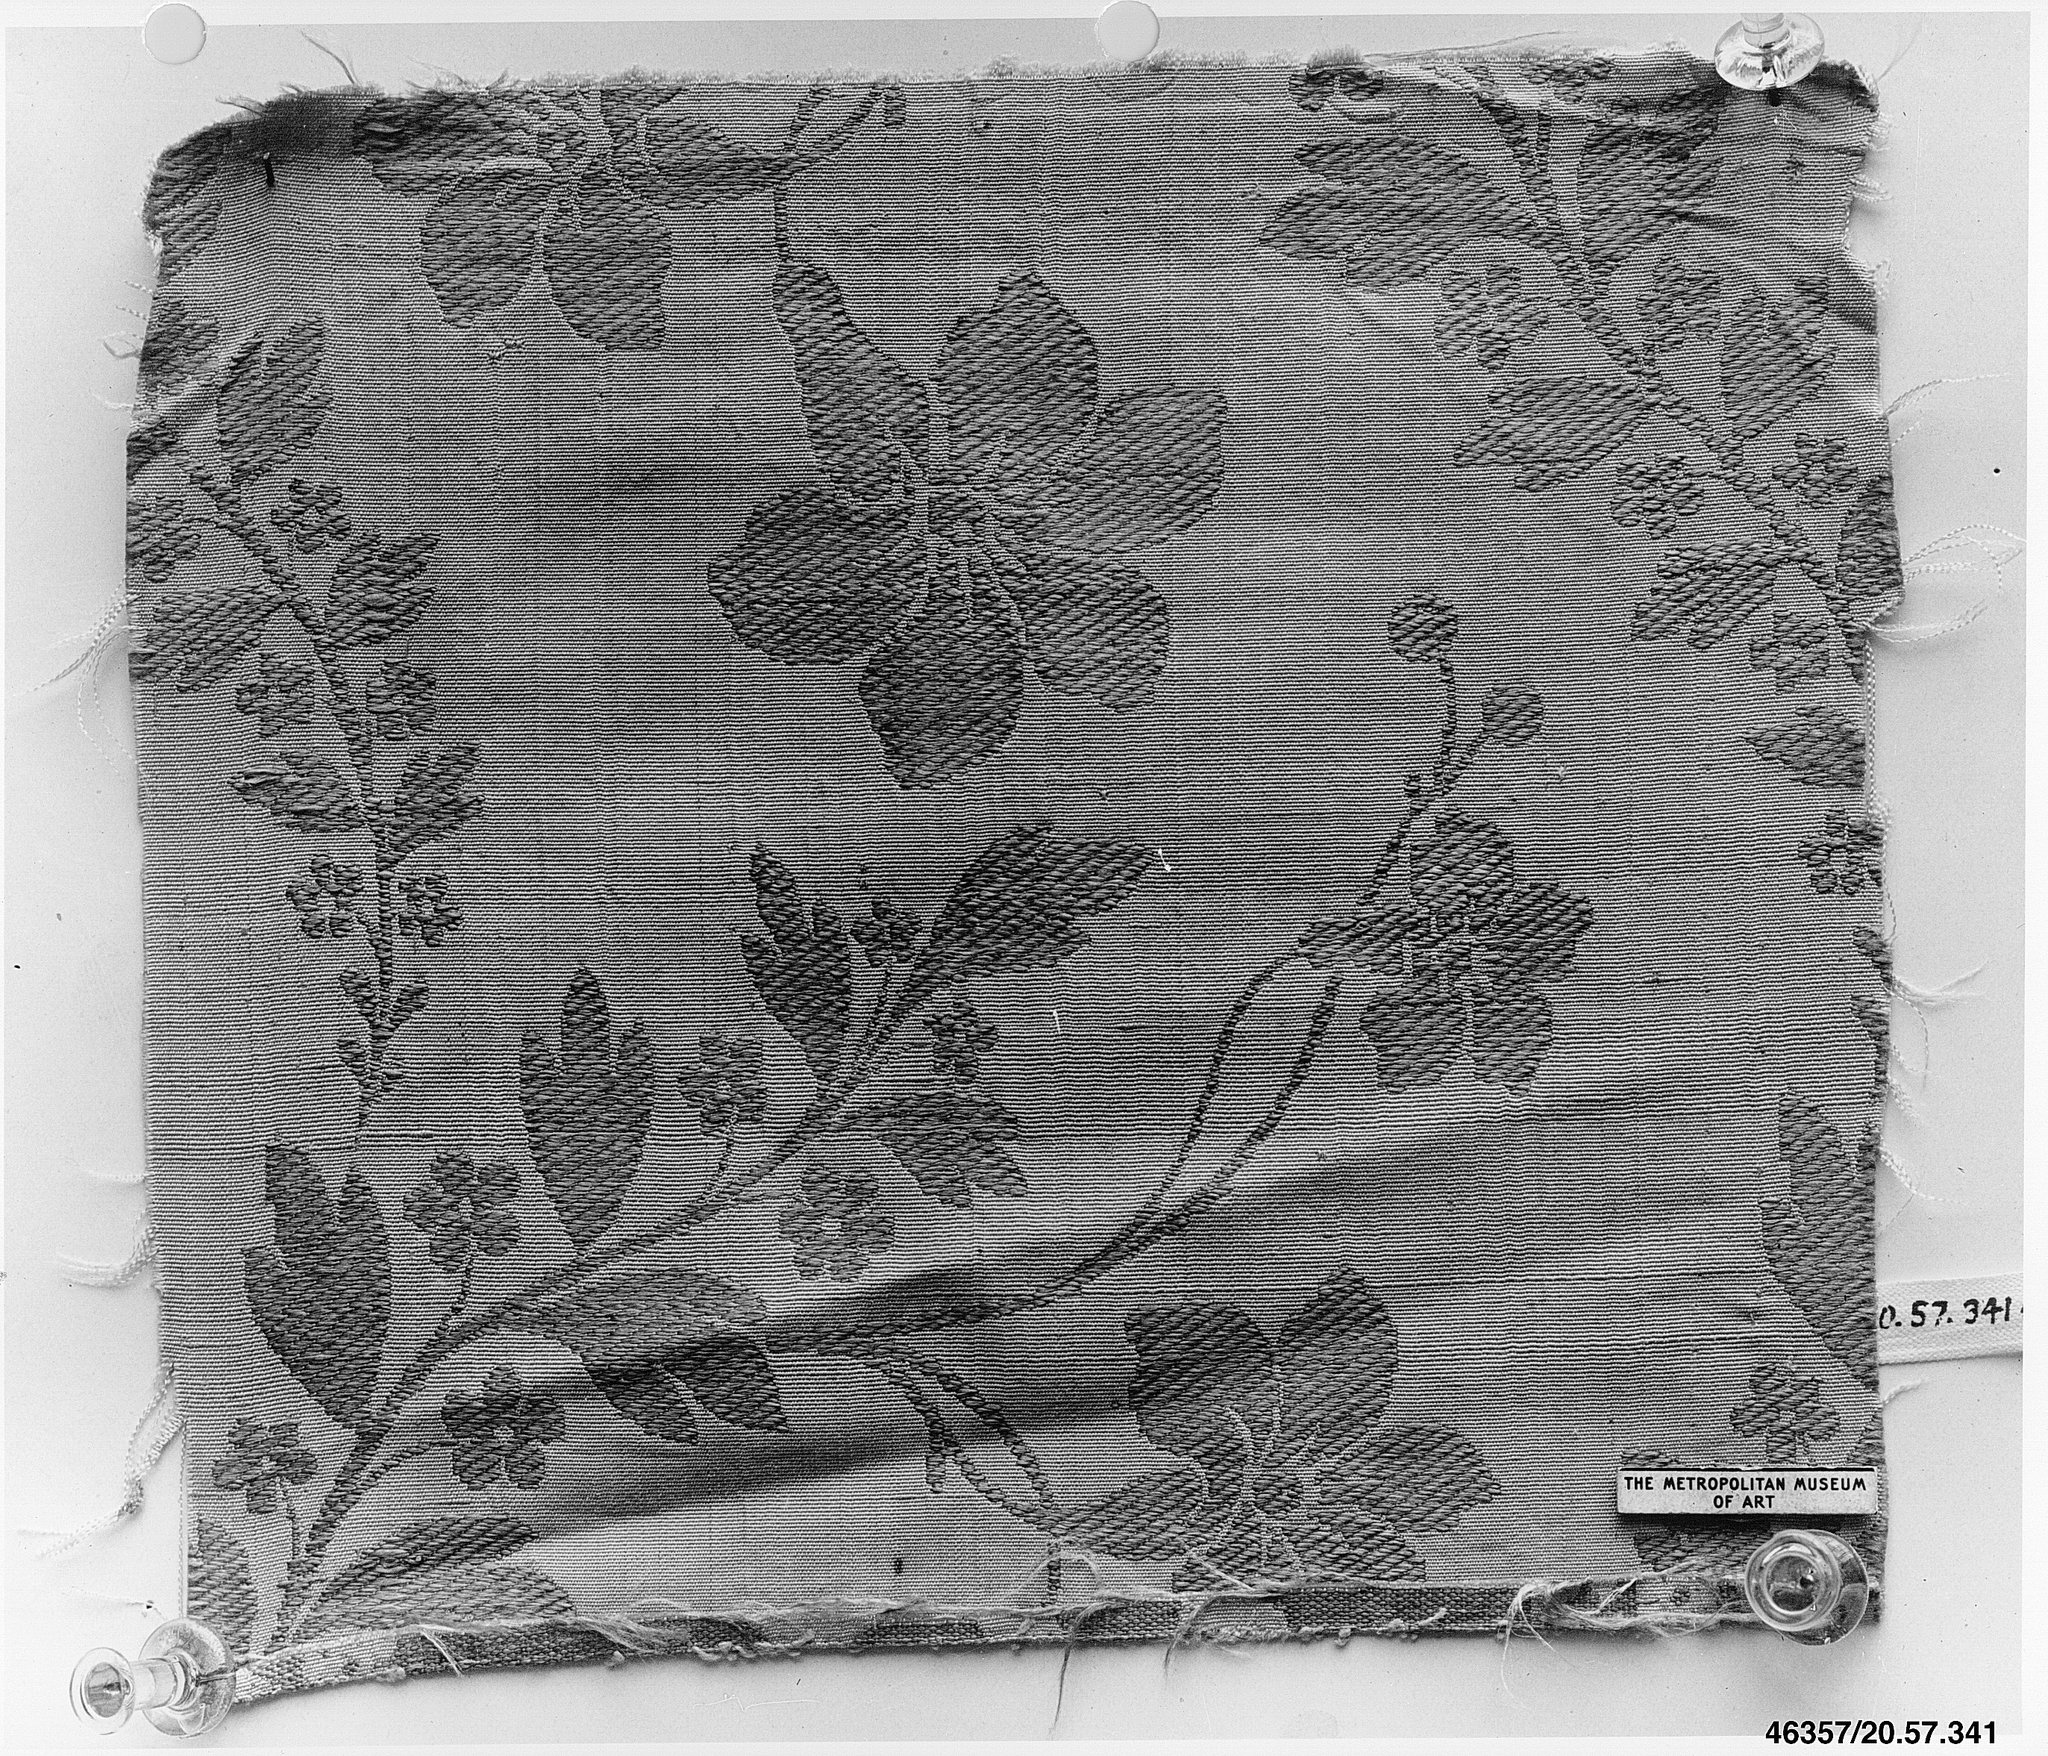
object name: piece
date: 1750-1775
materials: silk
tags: flowers,leaves